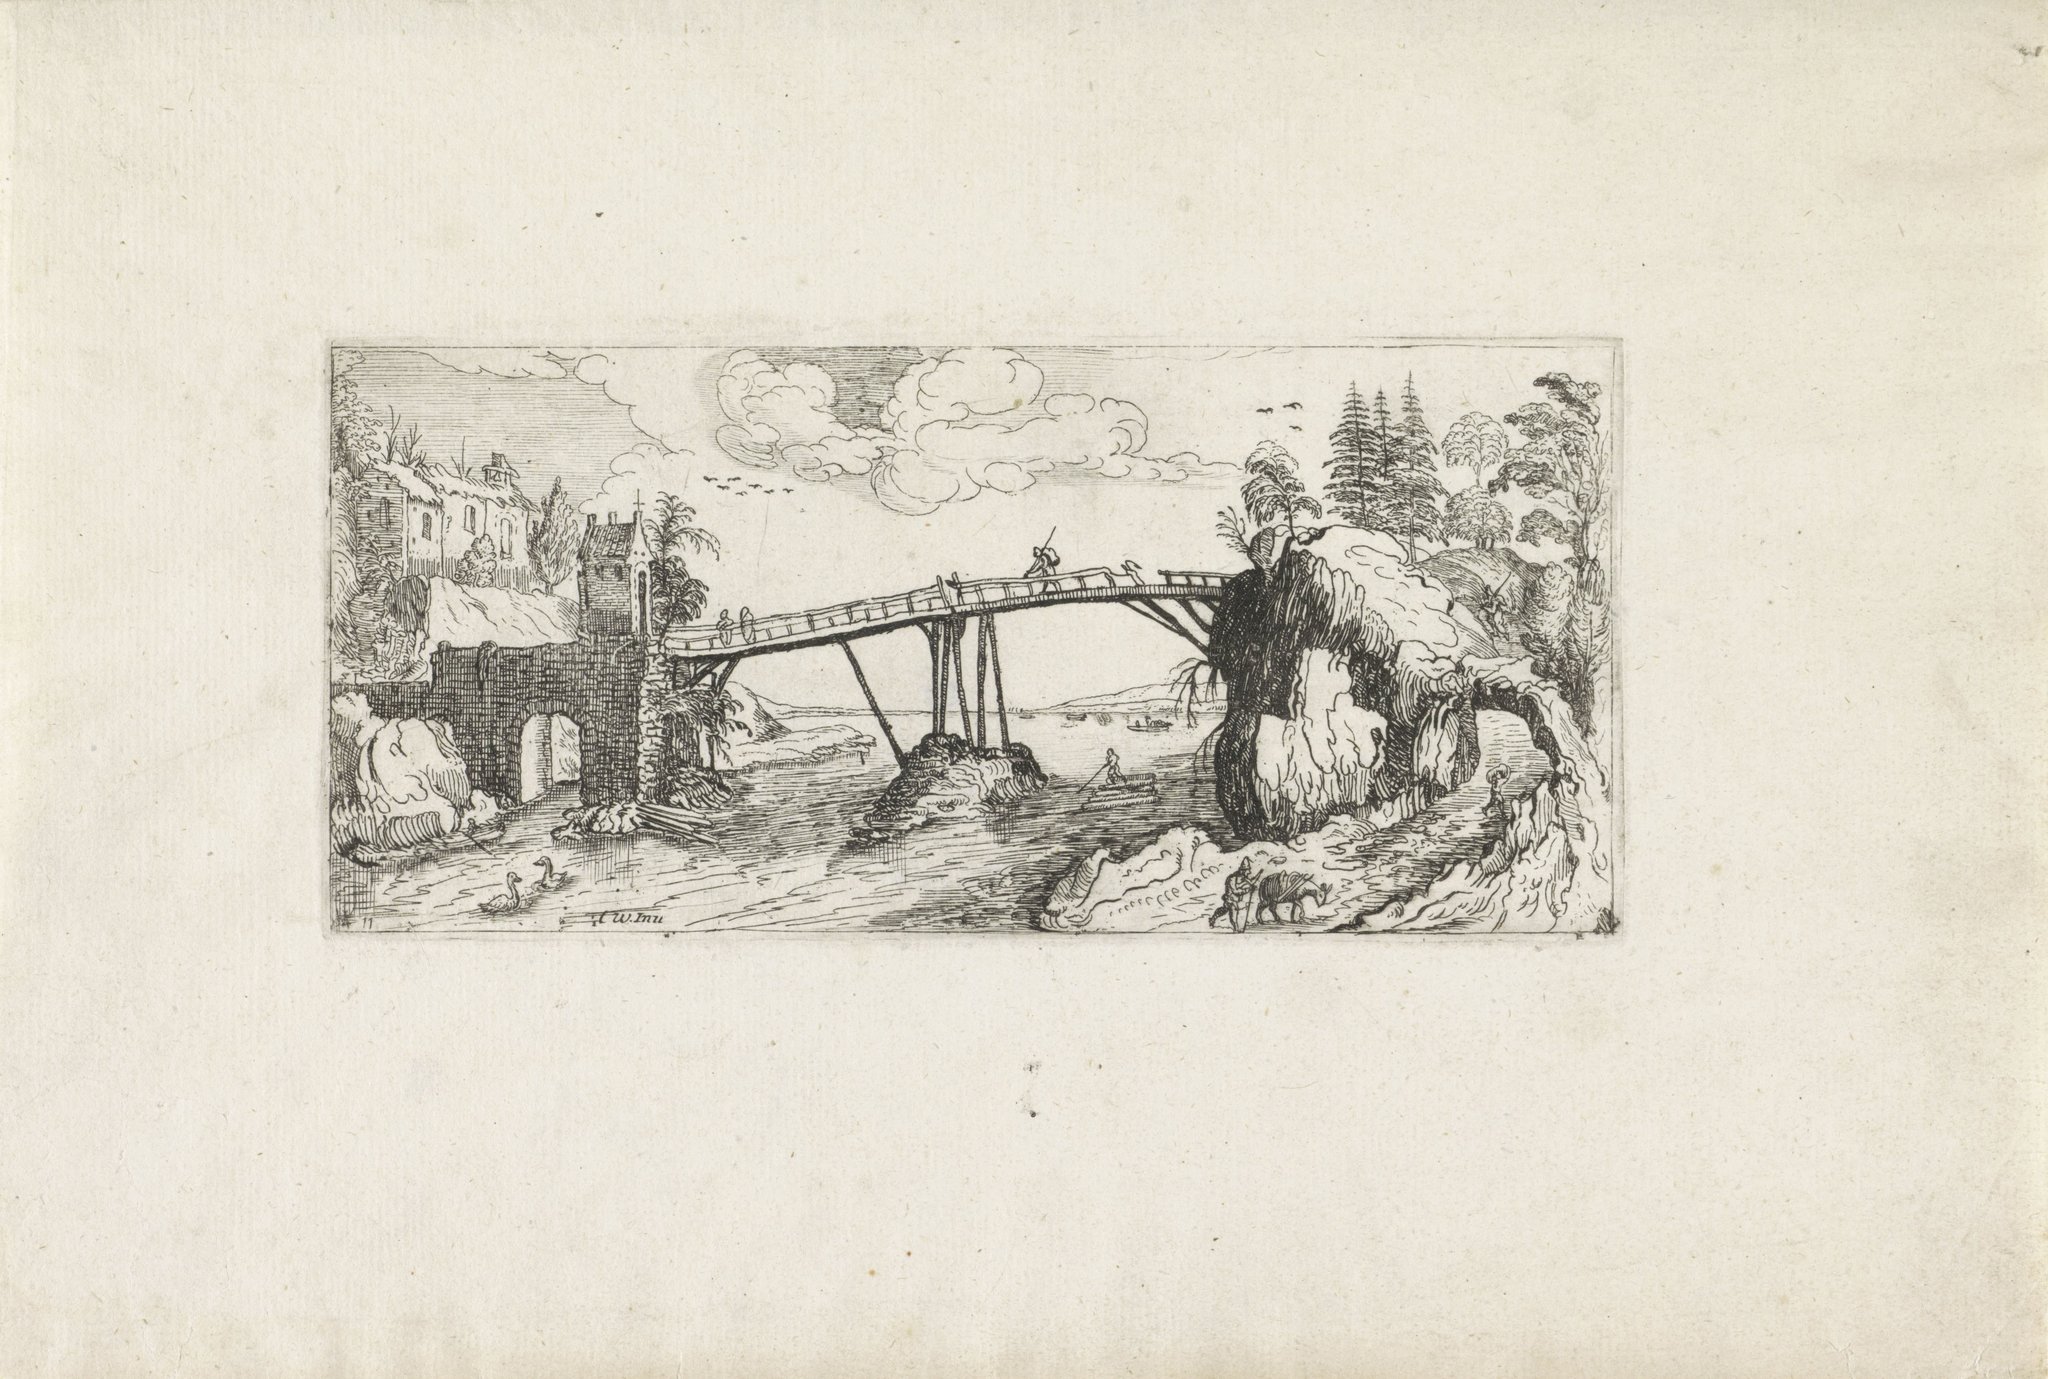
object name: print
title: Heuvelachtig landschap met een brug over een rivier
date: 1614-1618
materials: paper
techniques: etching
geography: haarlem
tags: bridge in village across river, canal, etc.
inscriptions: collector's mark: Lugt 2760, collector's mark: Lugt 2228